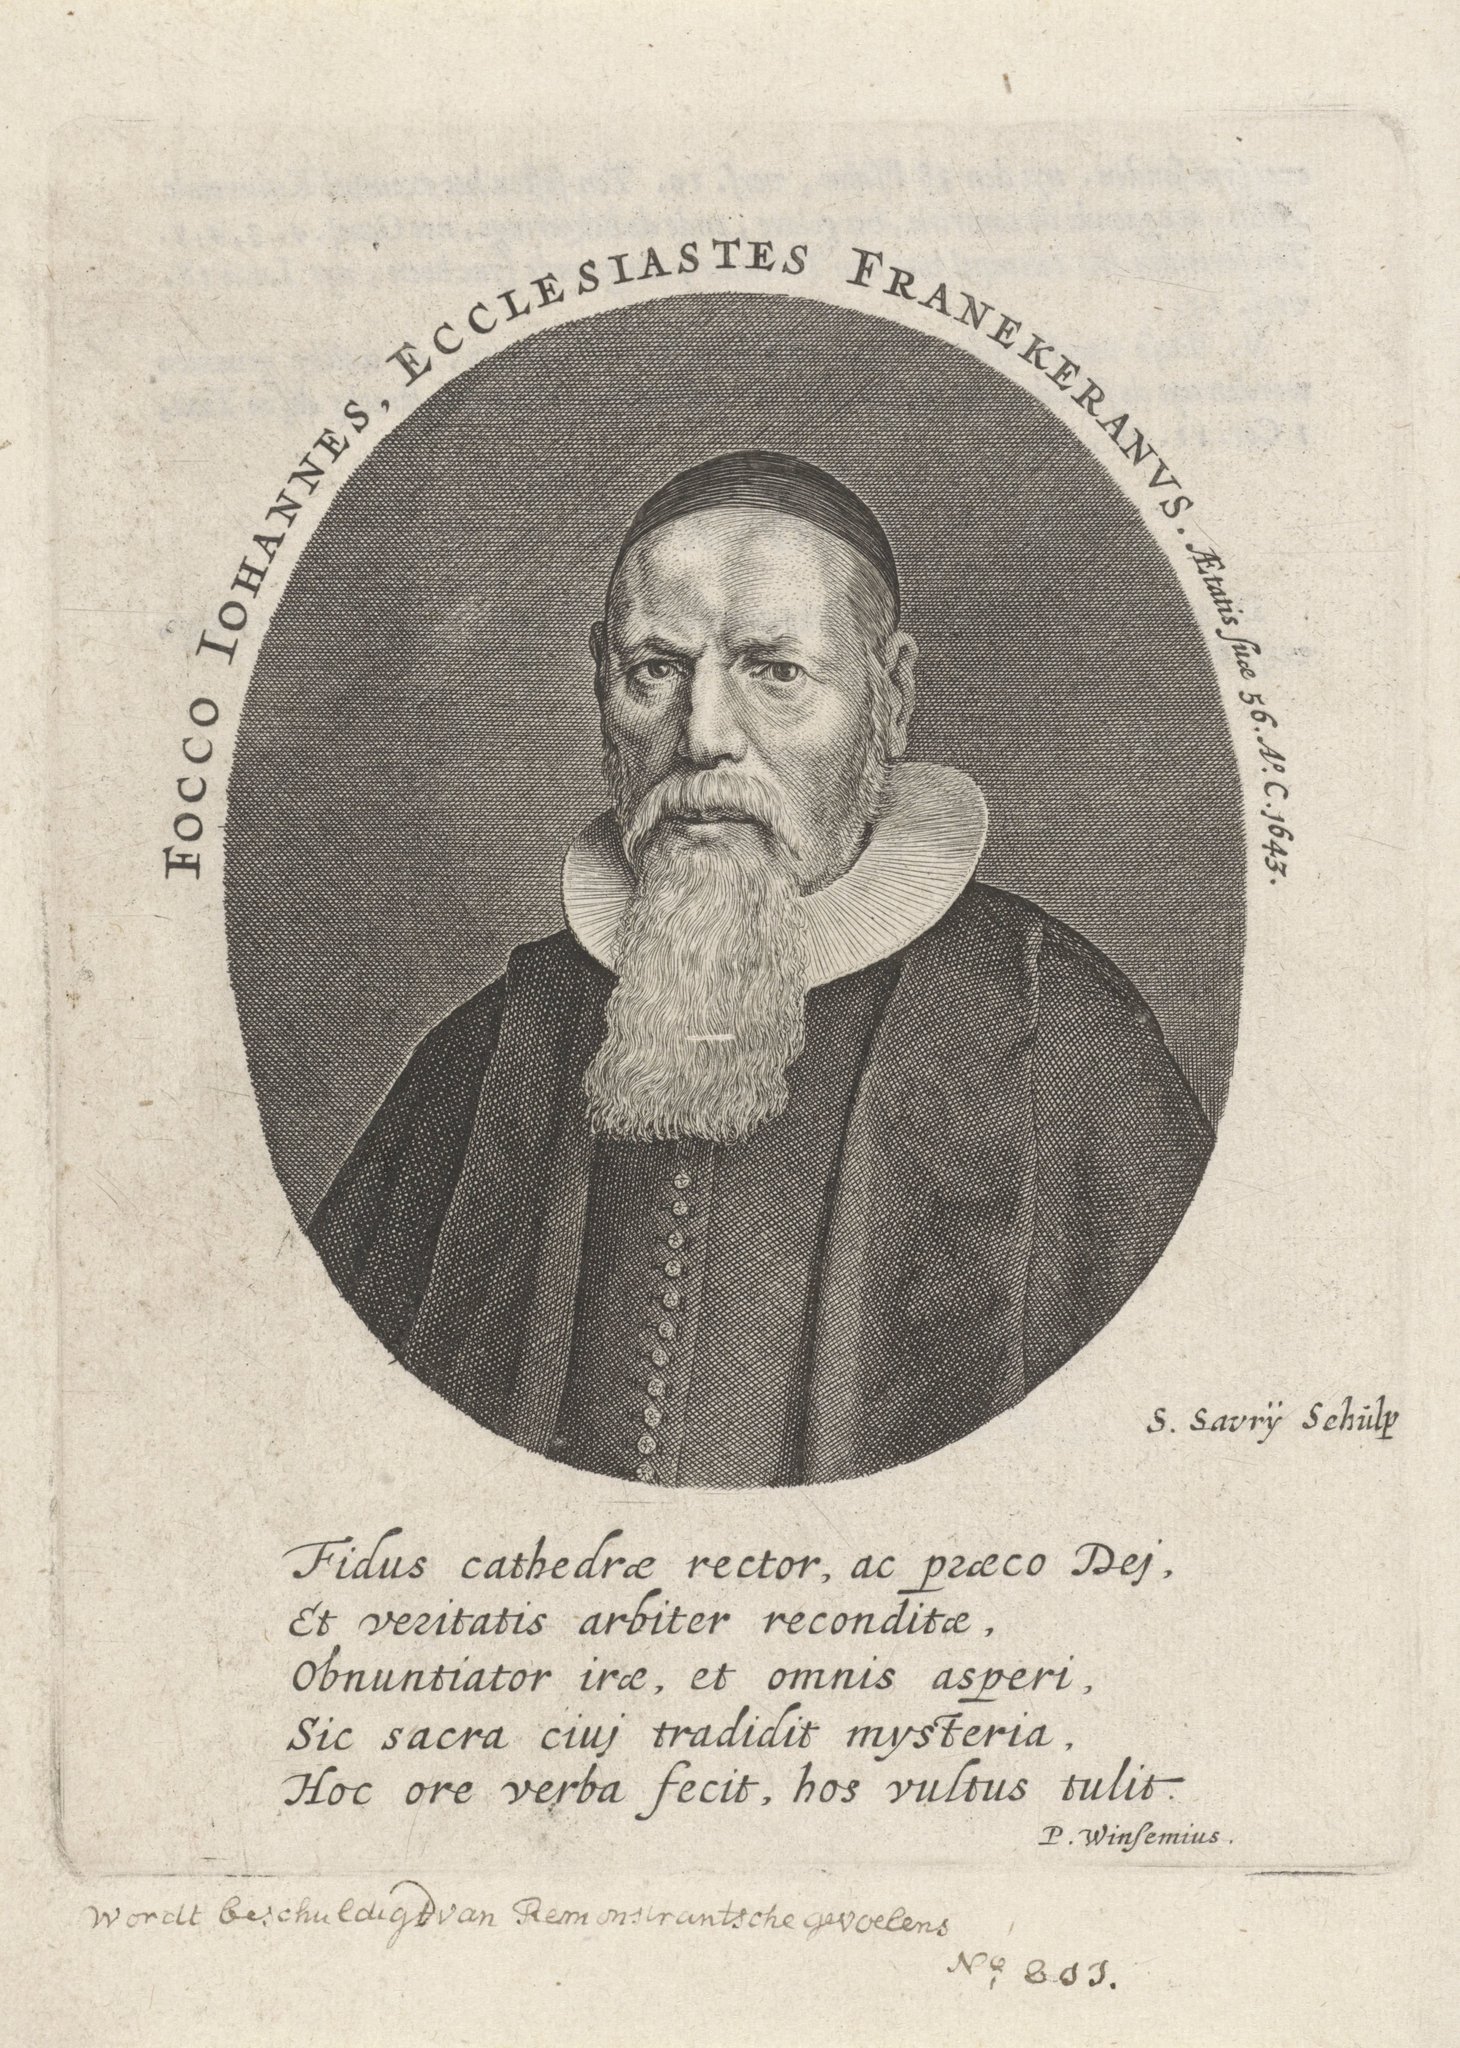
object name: book illustration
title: Portret van Johannes Focco, predikant te Franeker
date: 1643-1665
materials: paper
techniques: engraving, letterpress printing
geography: amsterdam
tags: predikant, johannes focco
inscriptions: inscription: ‘Wordt beschuldigt van Remonstrantsche gevoelens’, collector's mark: Lugt 2228